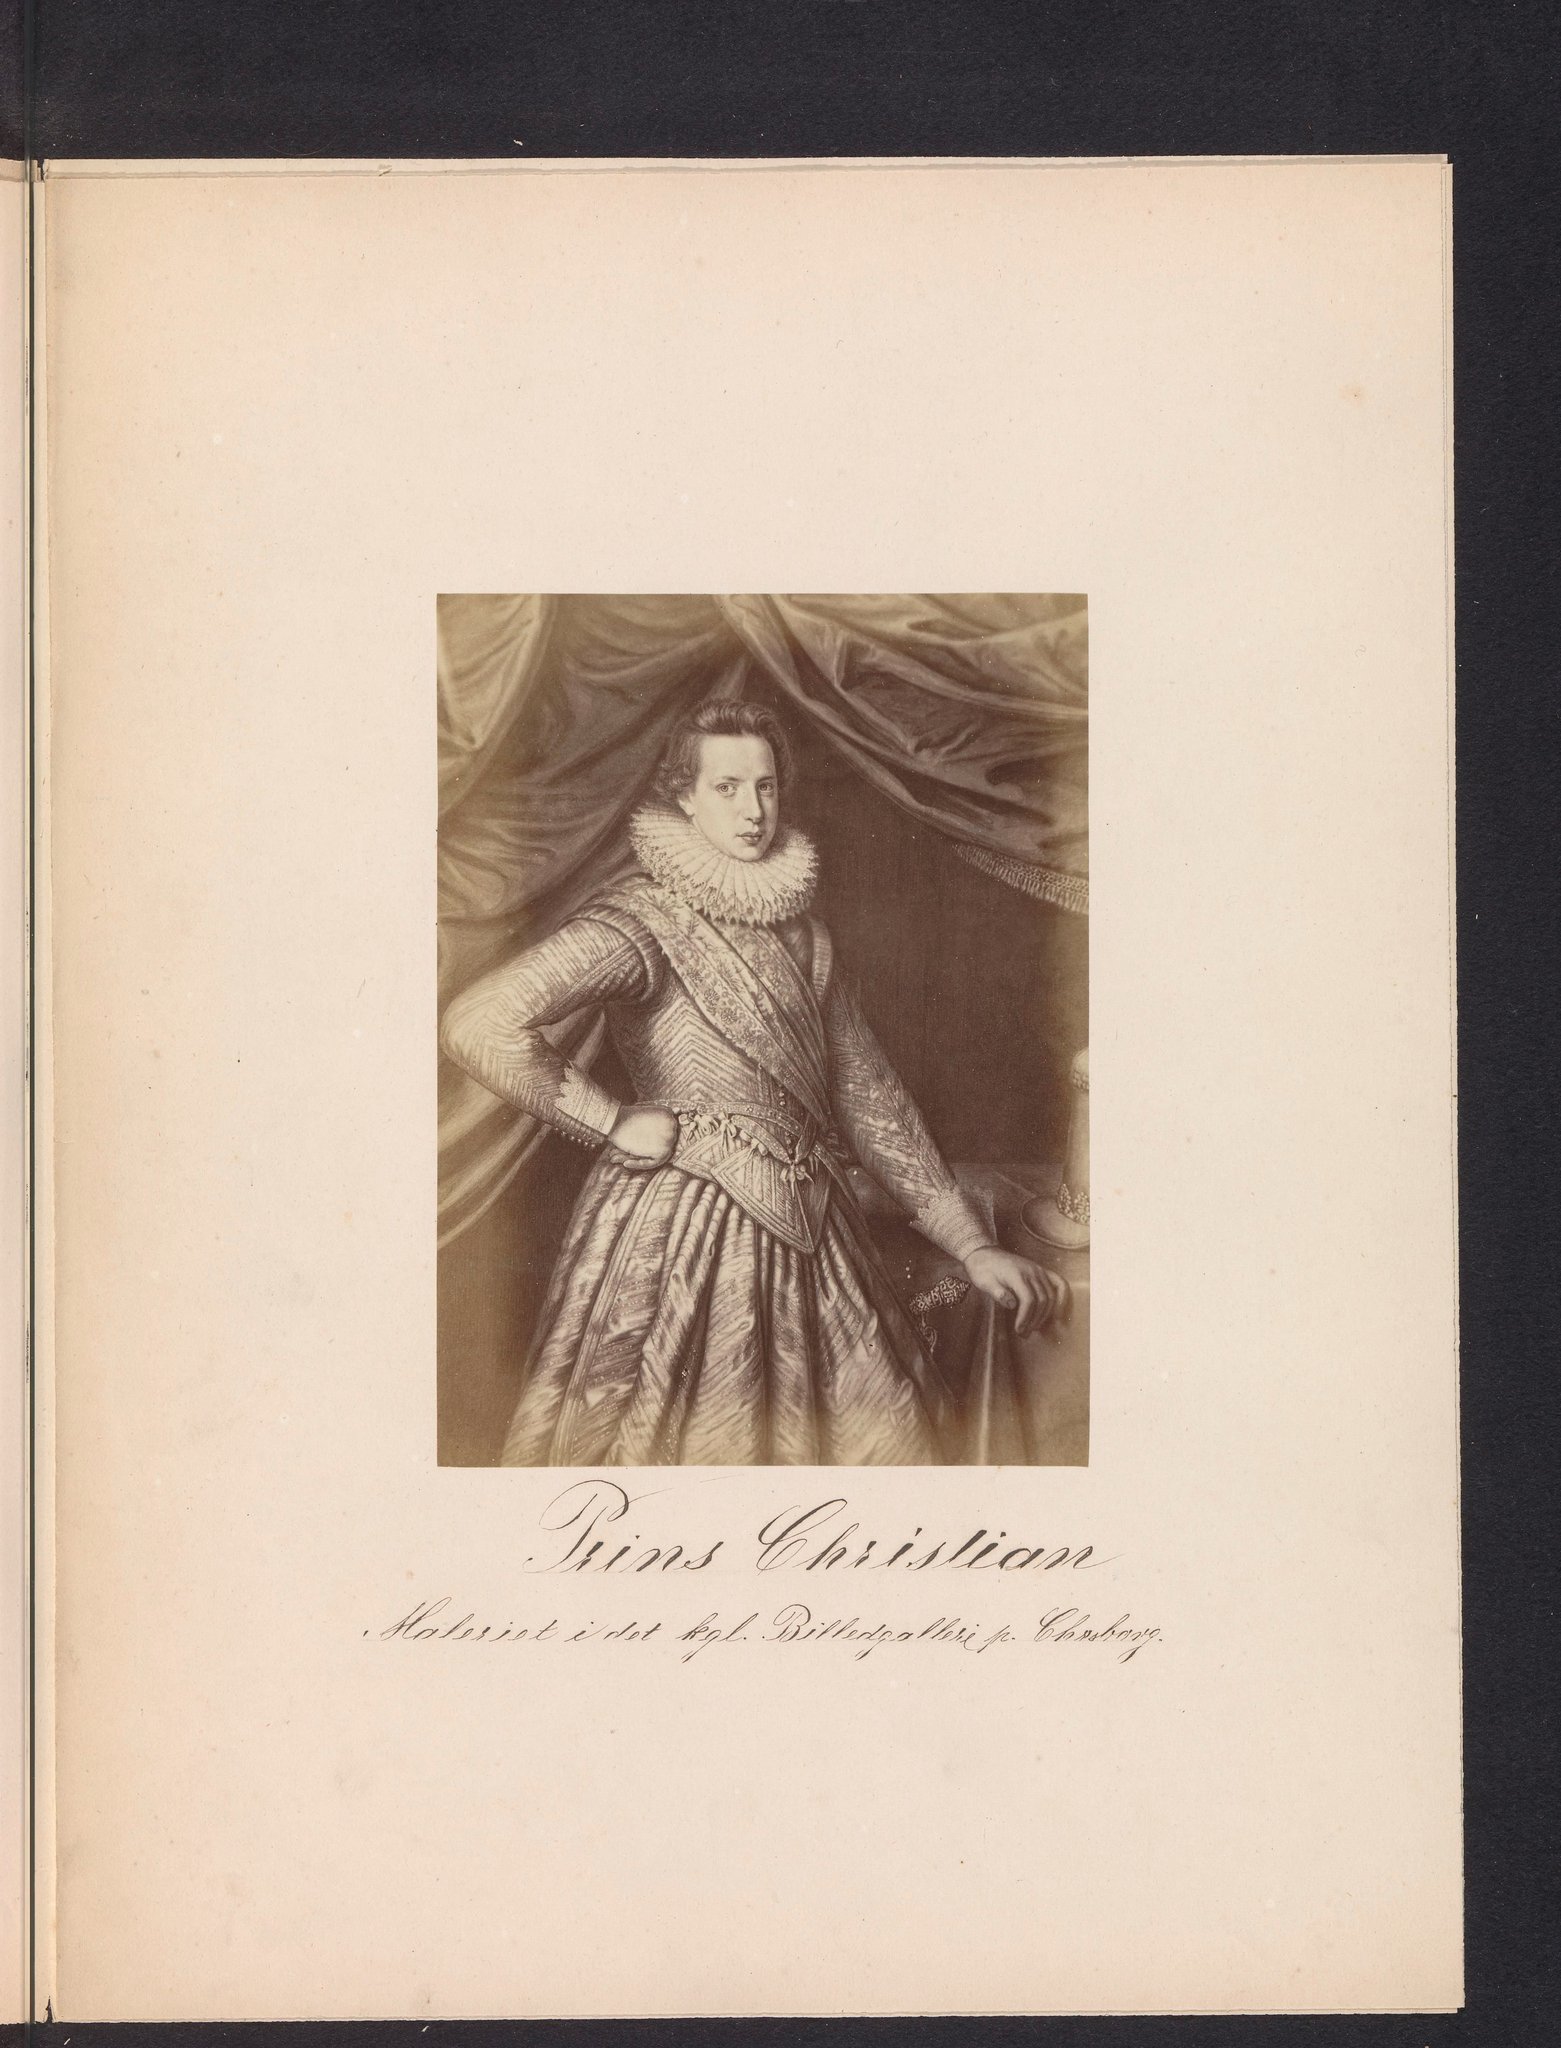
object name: page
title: Prins Christian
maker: julius wulff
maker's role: fotograaf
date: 1858-1863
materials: photographic support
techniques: albumen print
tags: copenhagen (city), crown prince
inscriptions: inscription: ‘Maleriet i det kgl. Billedgalleri paa Christiansborg Slot.’